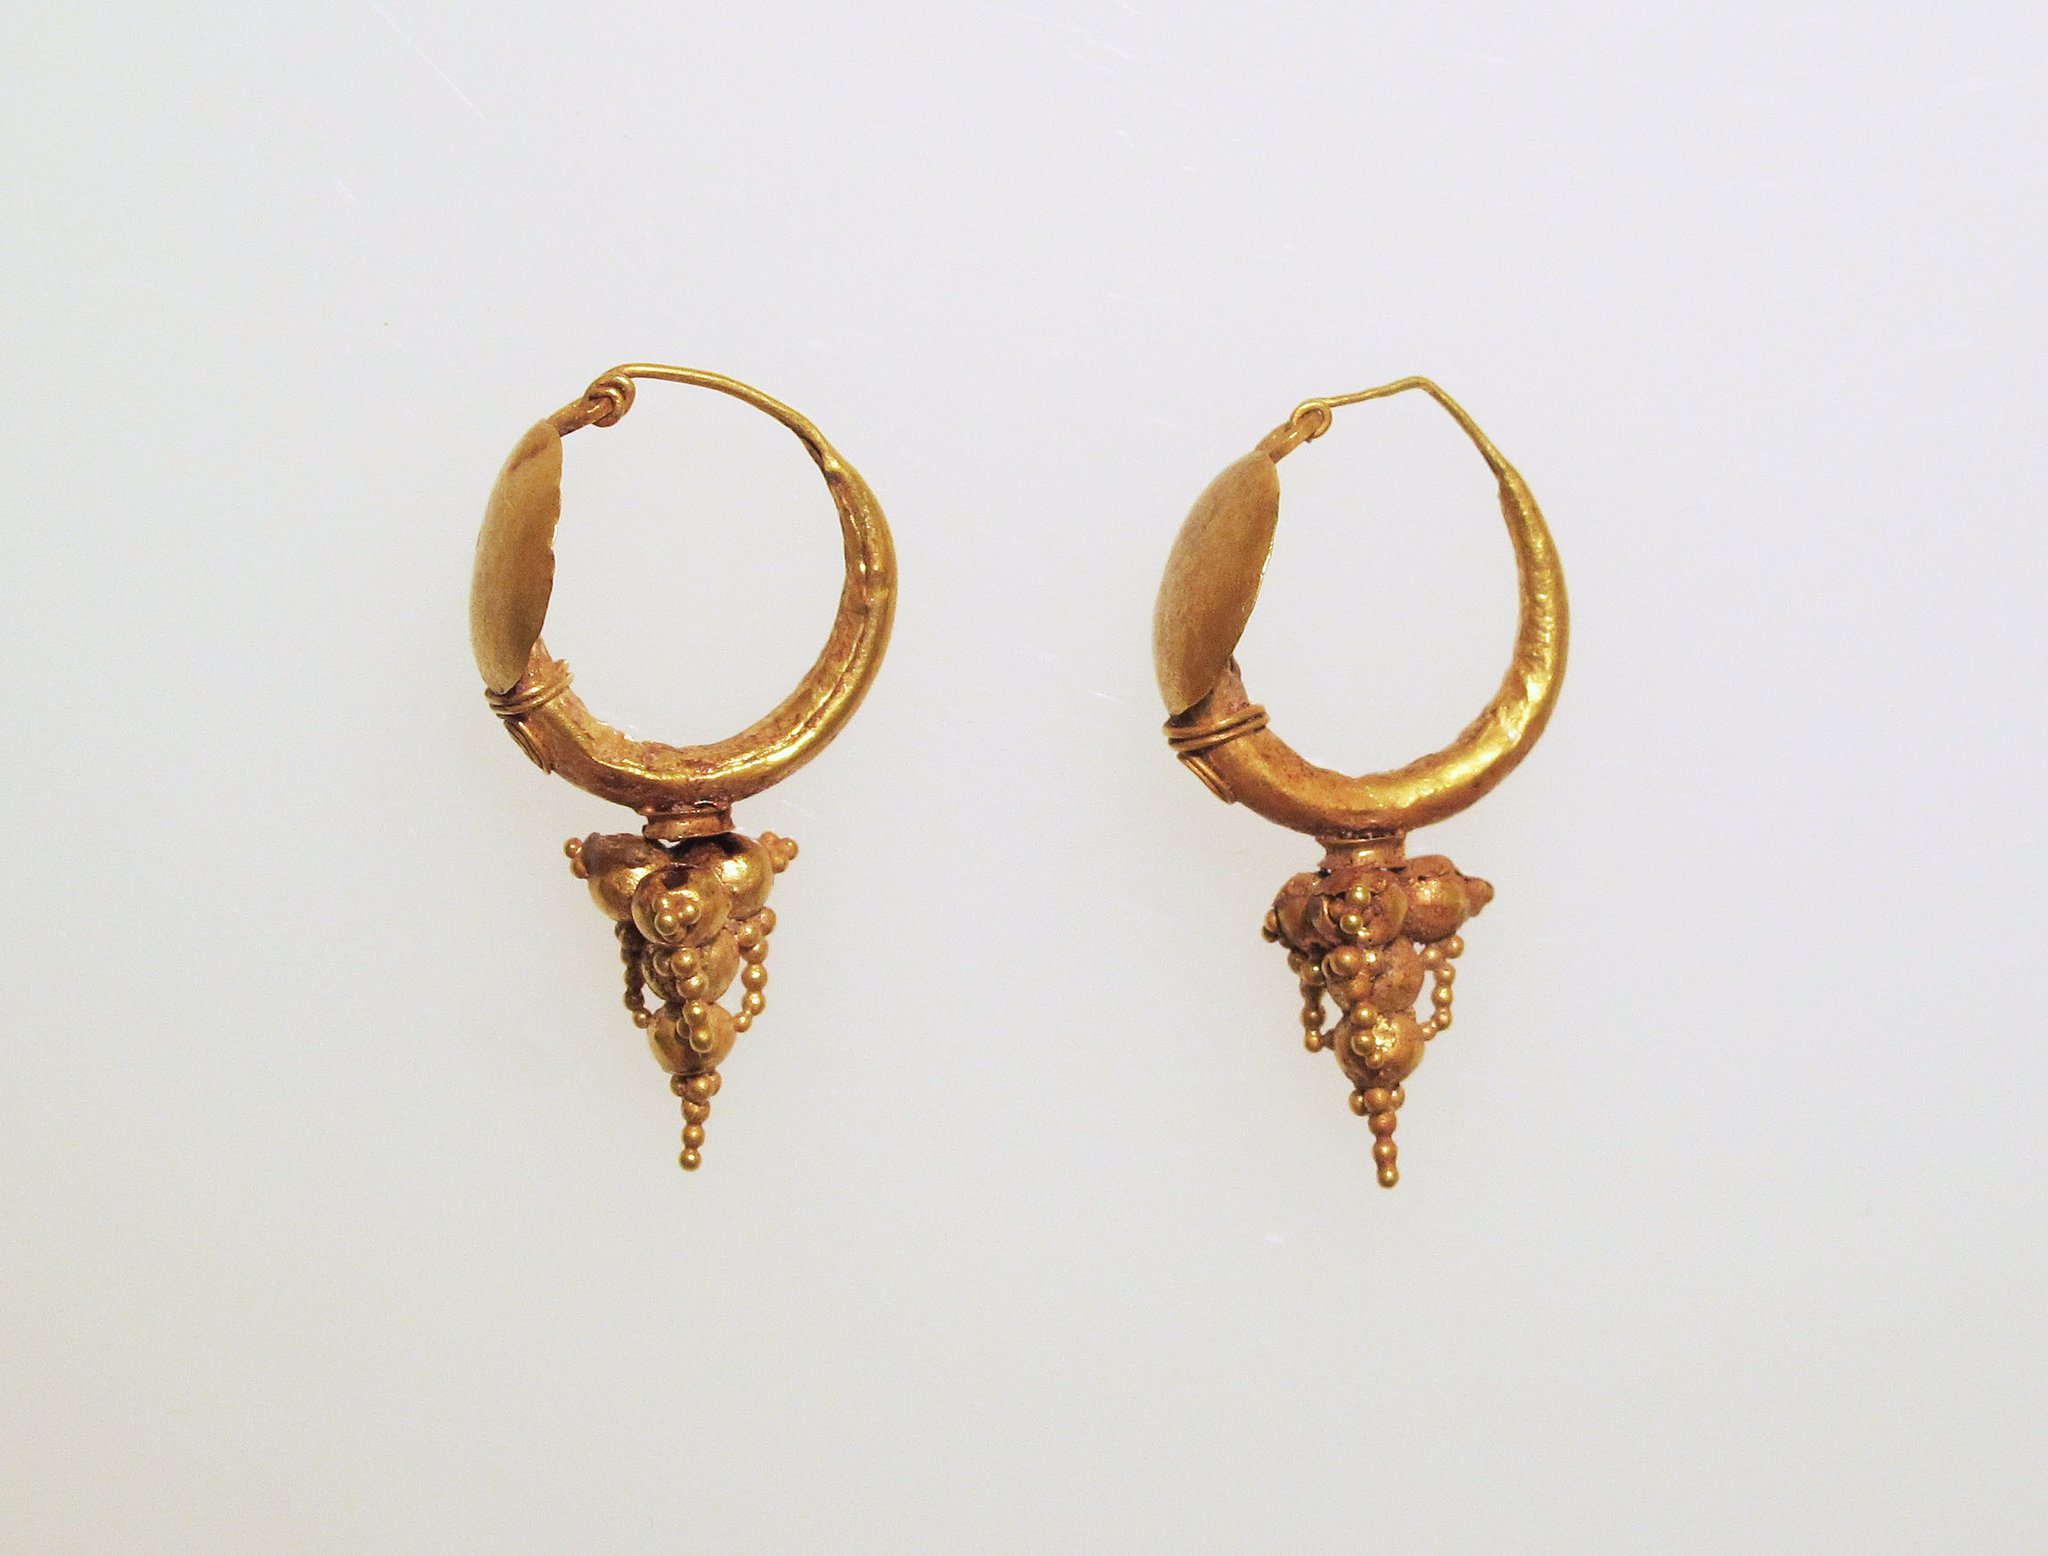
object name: earring with hook and eye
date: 7000 BCE-330 CE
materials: gold